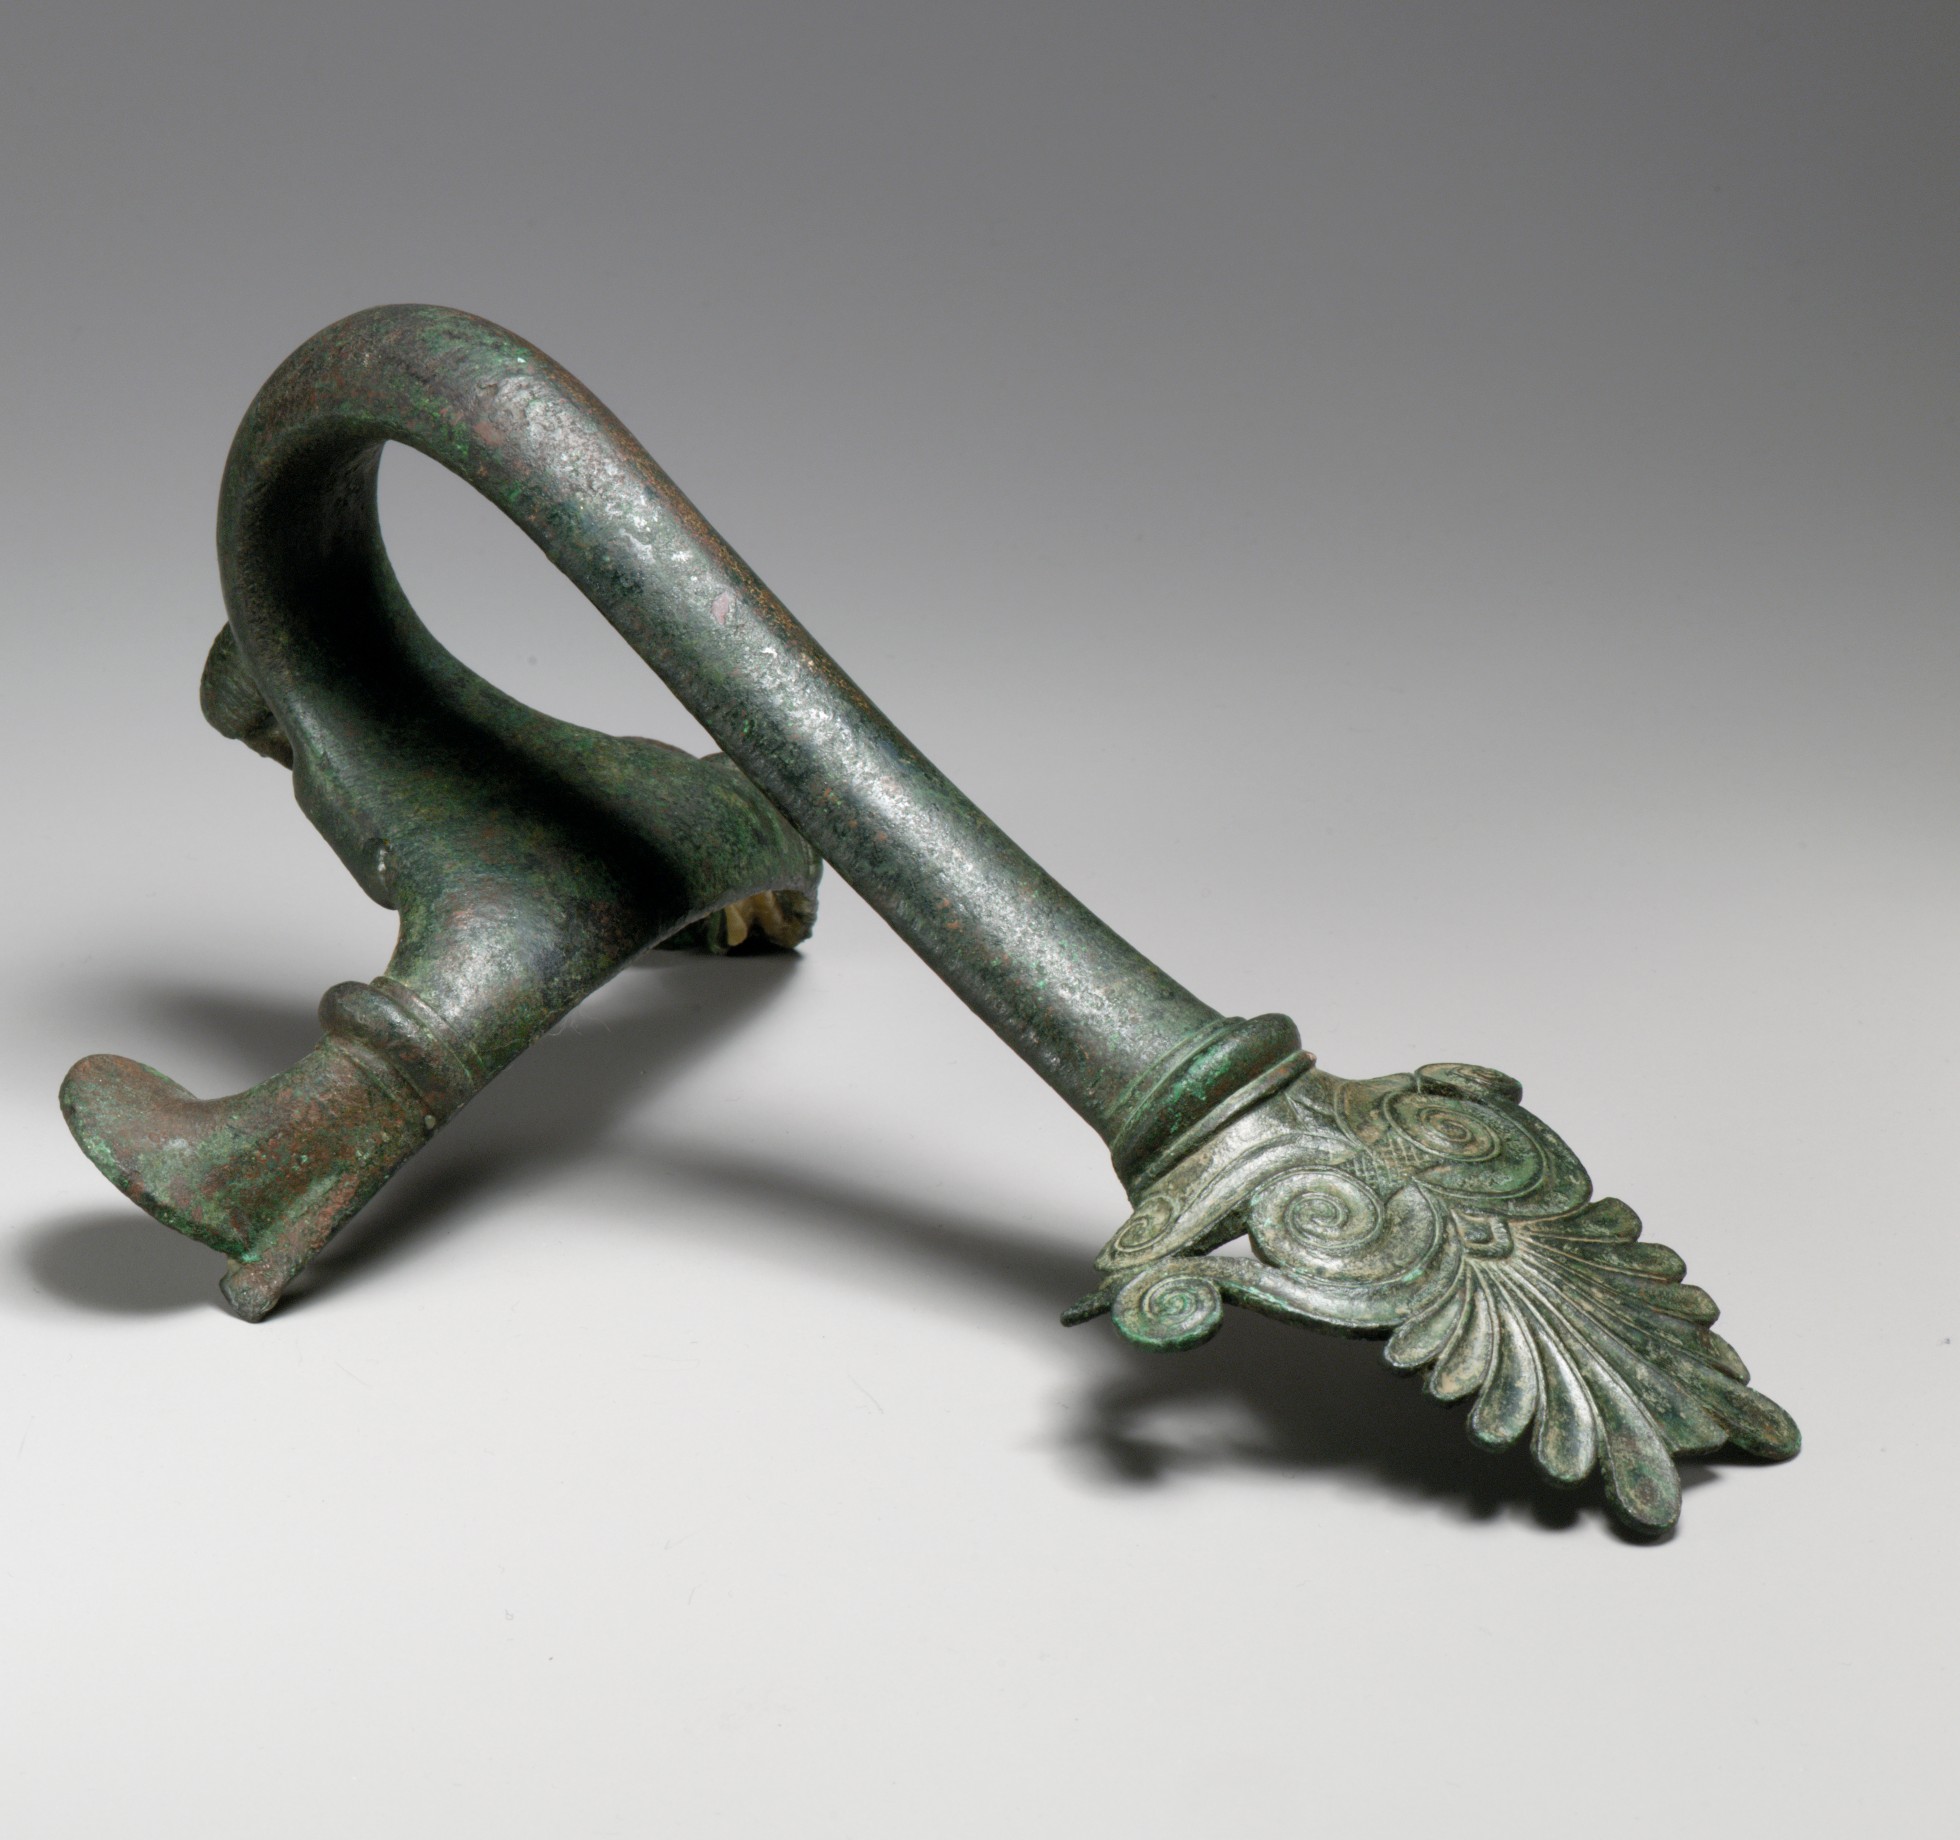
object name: handle of a hydria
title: Bronze handle of a hydria (water jar)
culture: greek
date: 500-476 BCE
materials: bronze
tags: palmettes